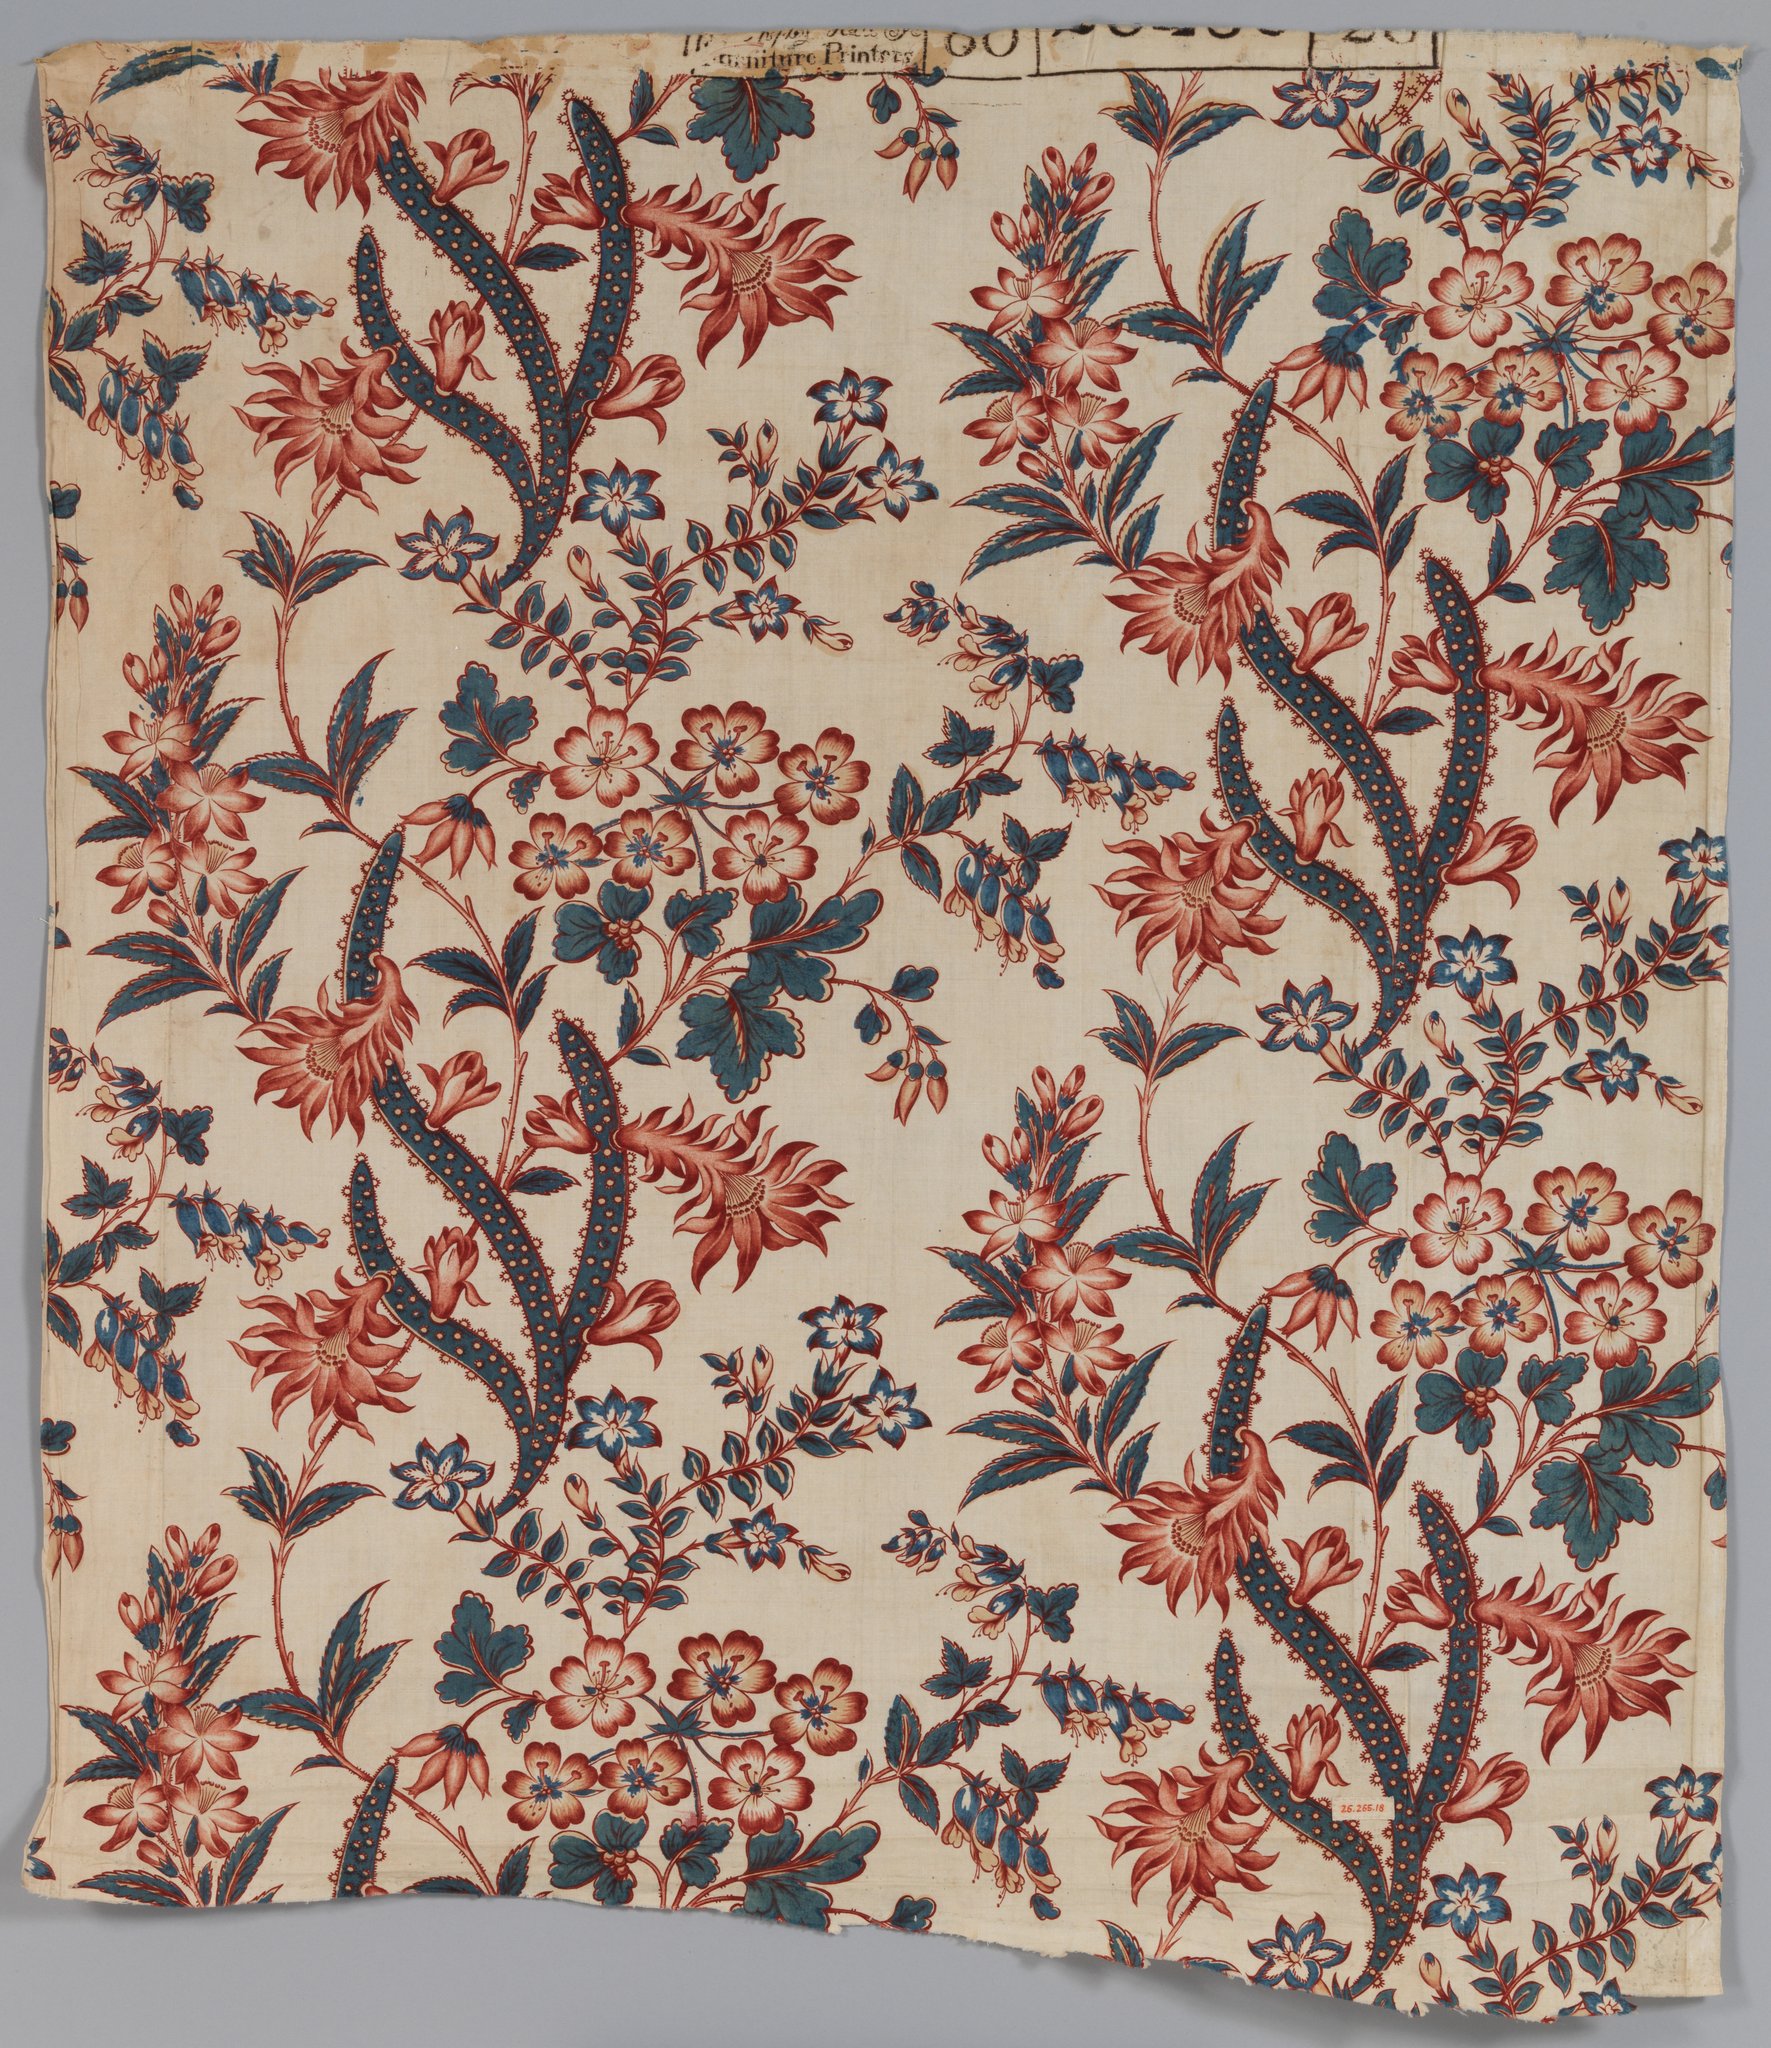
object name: piece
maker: stinton bros.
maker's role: designer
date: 1831-1851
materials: cotton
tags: flowers,leaves